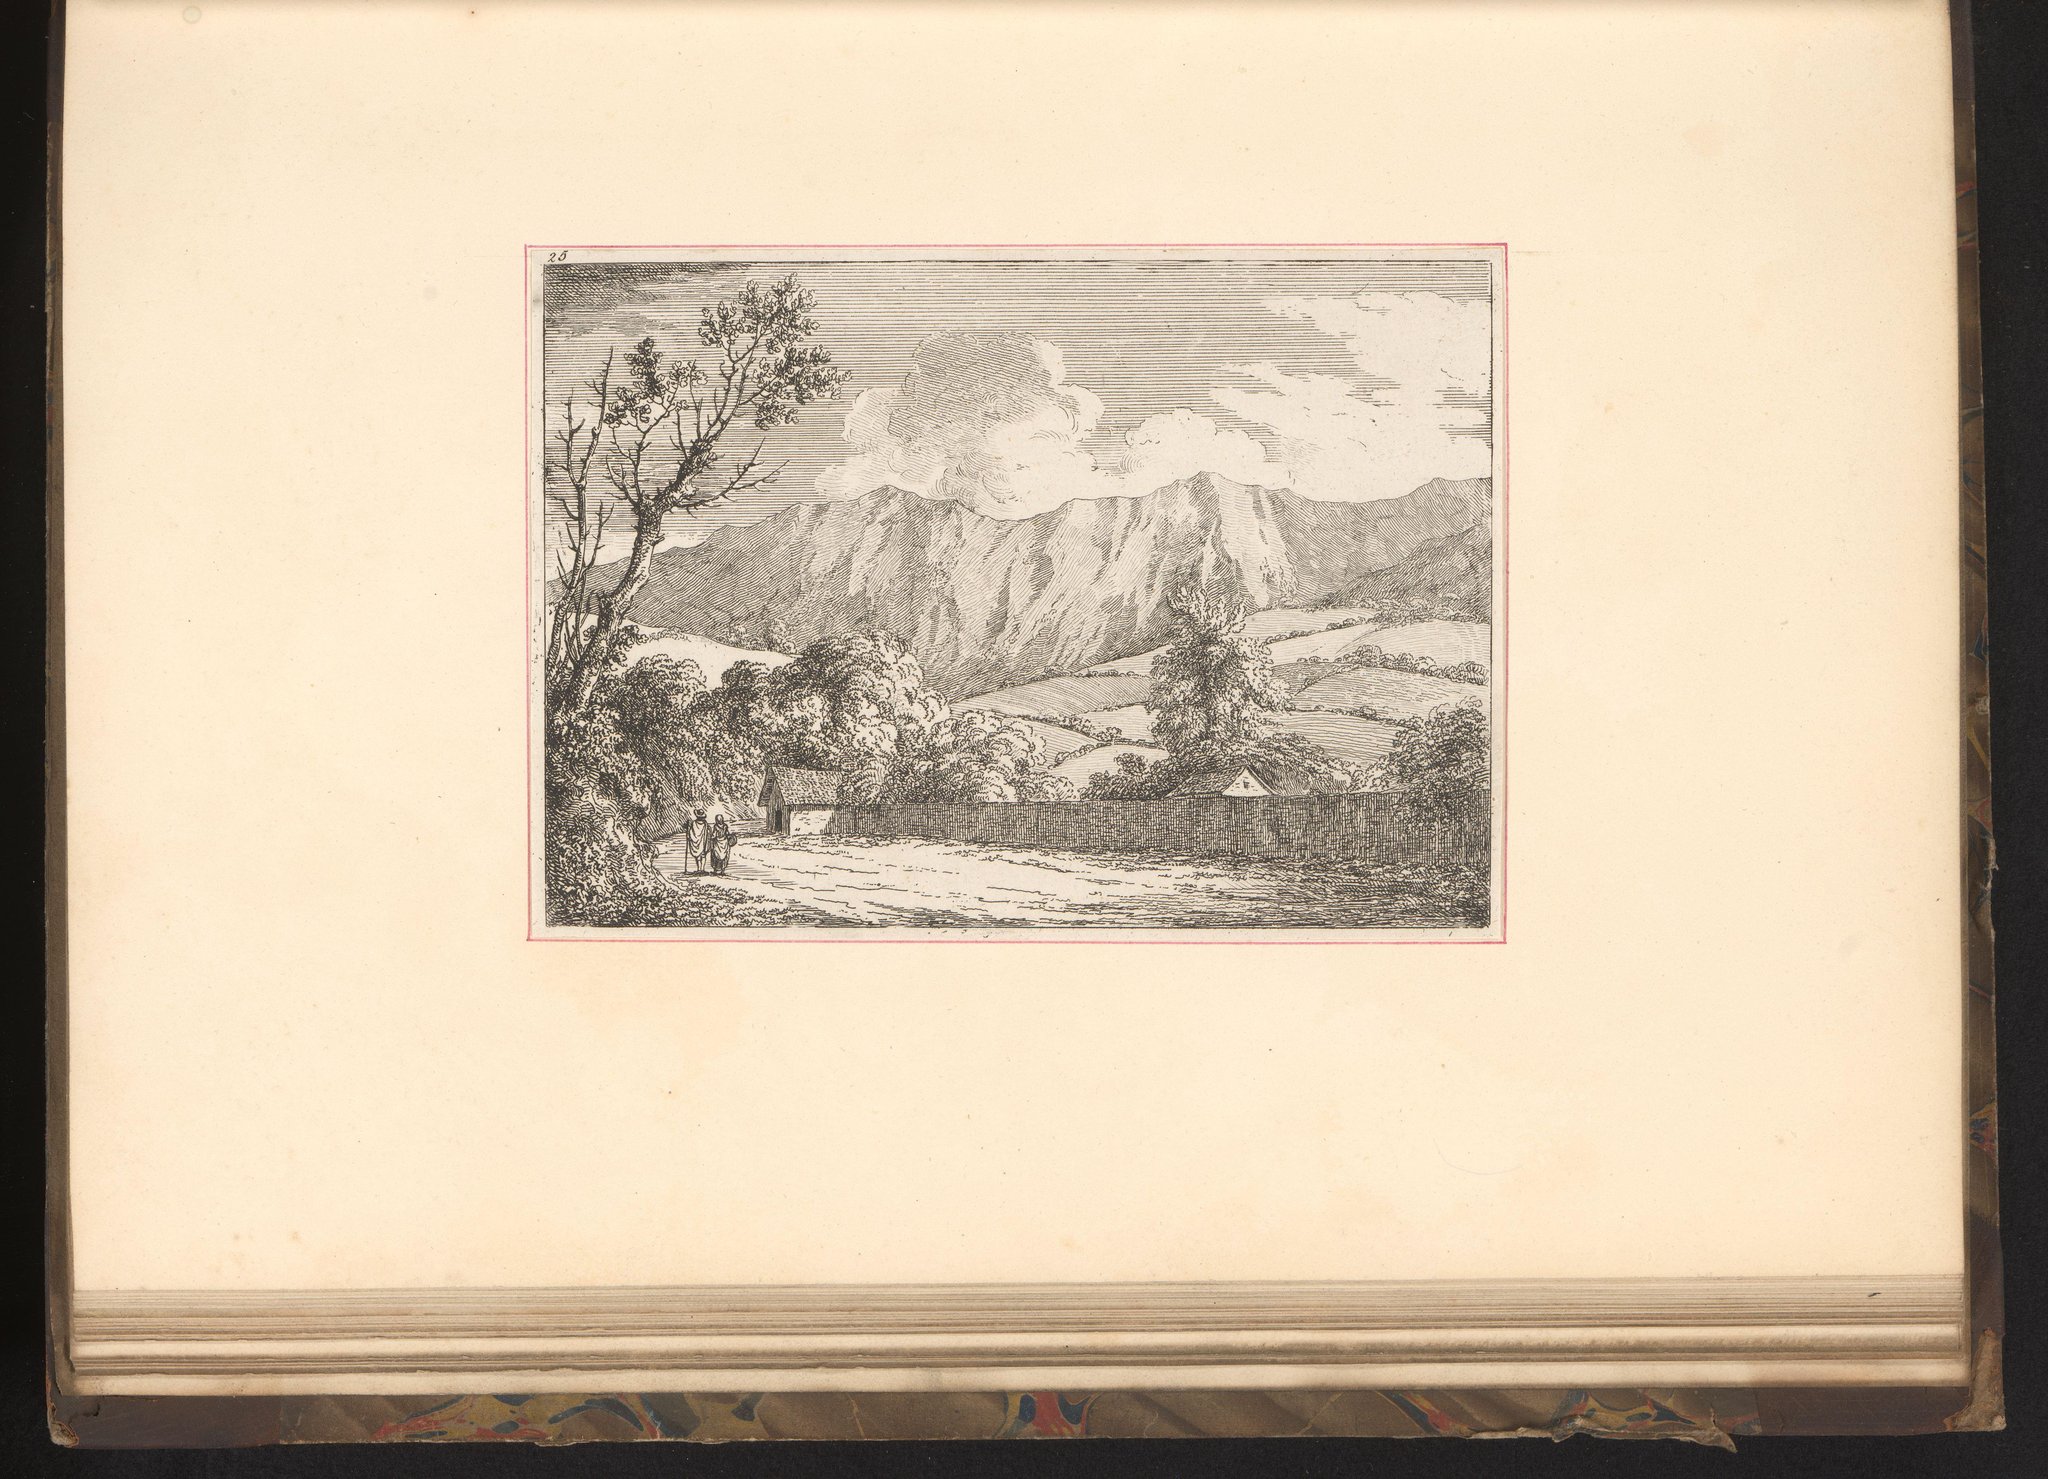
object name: album leaf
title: Etchings by E. Edwards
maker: edward edwards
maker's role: painter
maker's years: 1738-1806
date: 1748-1806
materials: paper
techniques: etching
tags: (high) hill (+ landscape with figures, staffage), city-walls (+ city(-scape) with figures, staffage)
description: Prent maakt deel uit van een serie van 51 prenten, bestaande uit twee delen met landschappen (36 prenten) en figuren en portretten (15 prenten), voor het eerst uitgegeven in Londen in 1790.